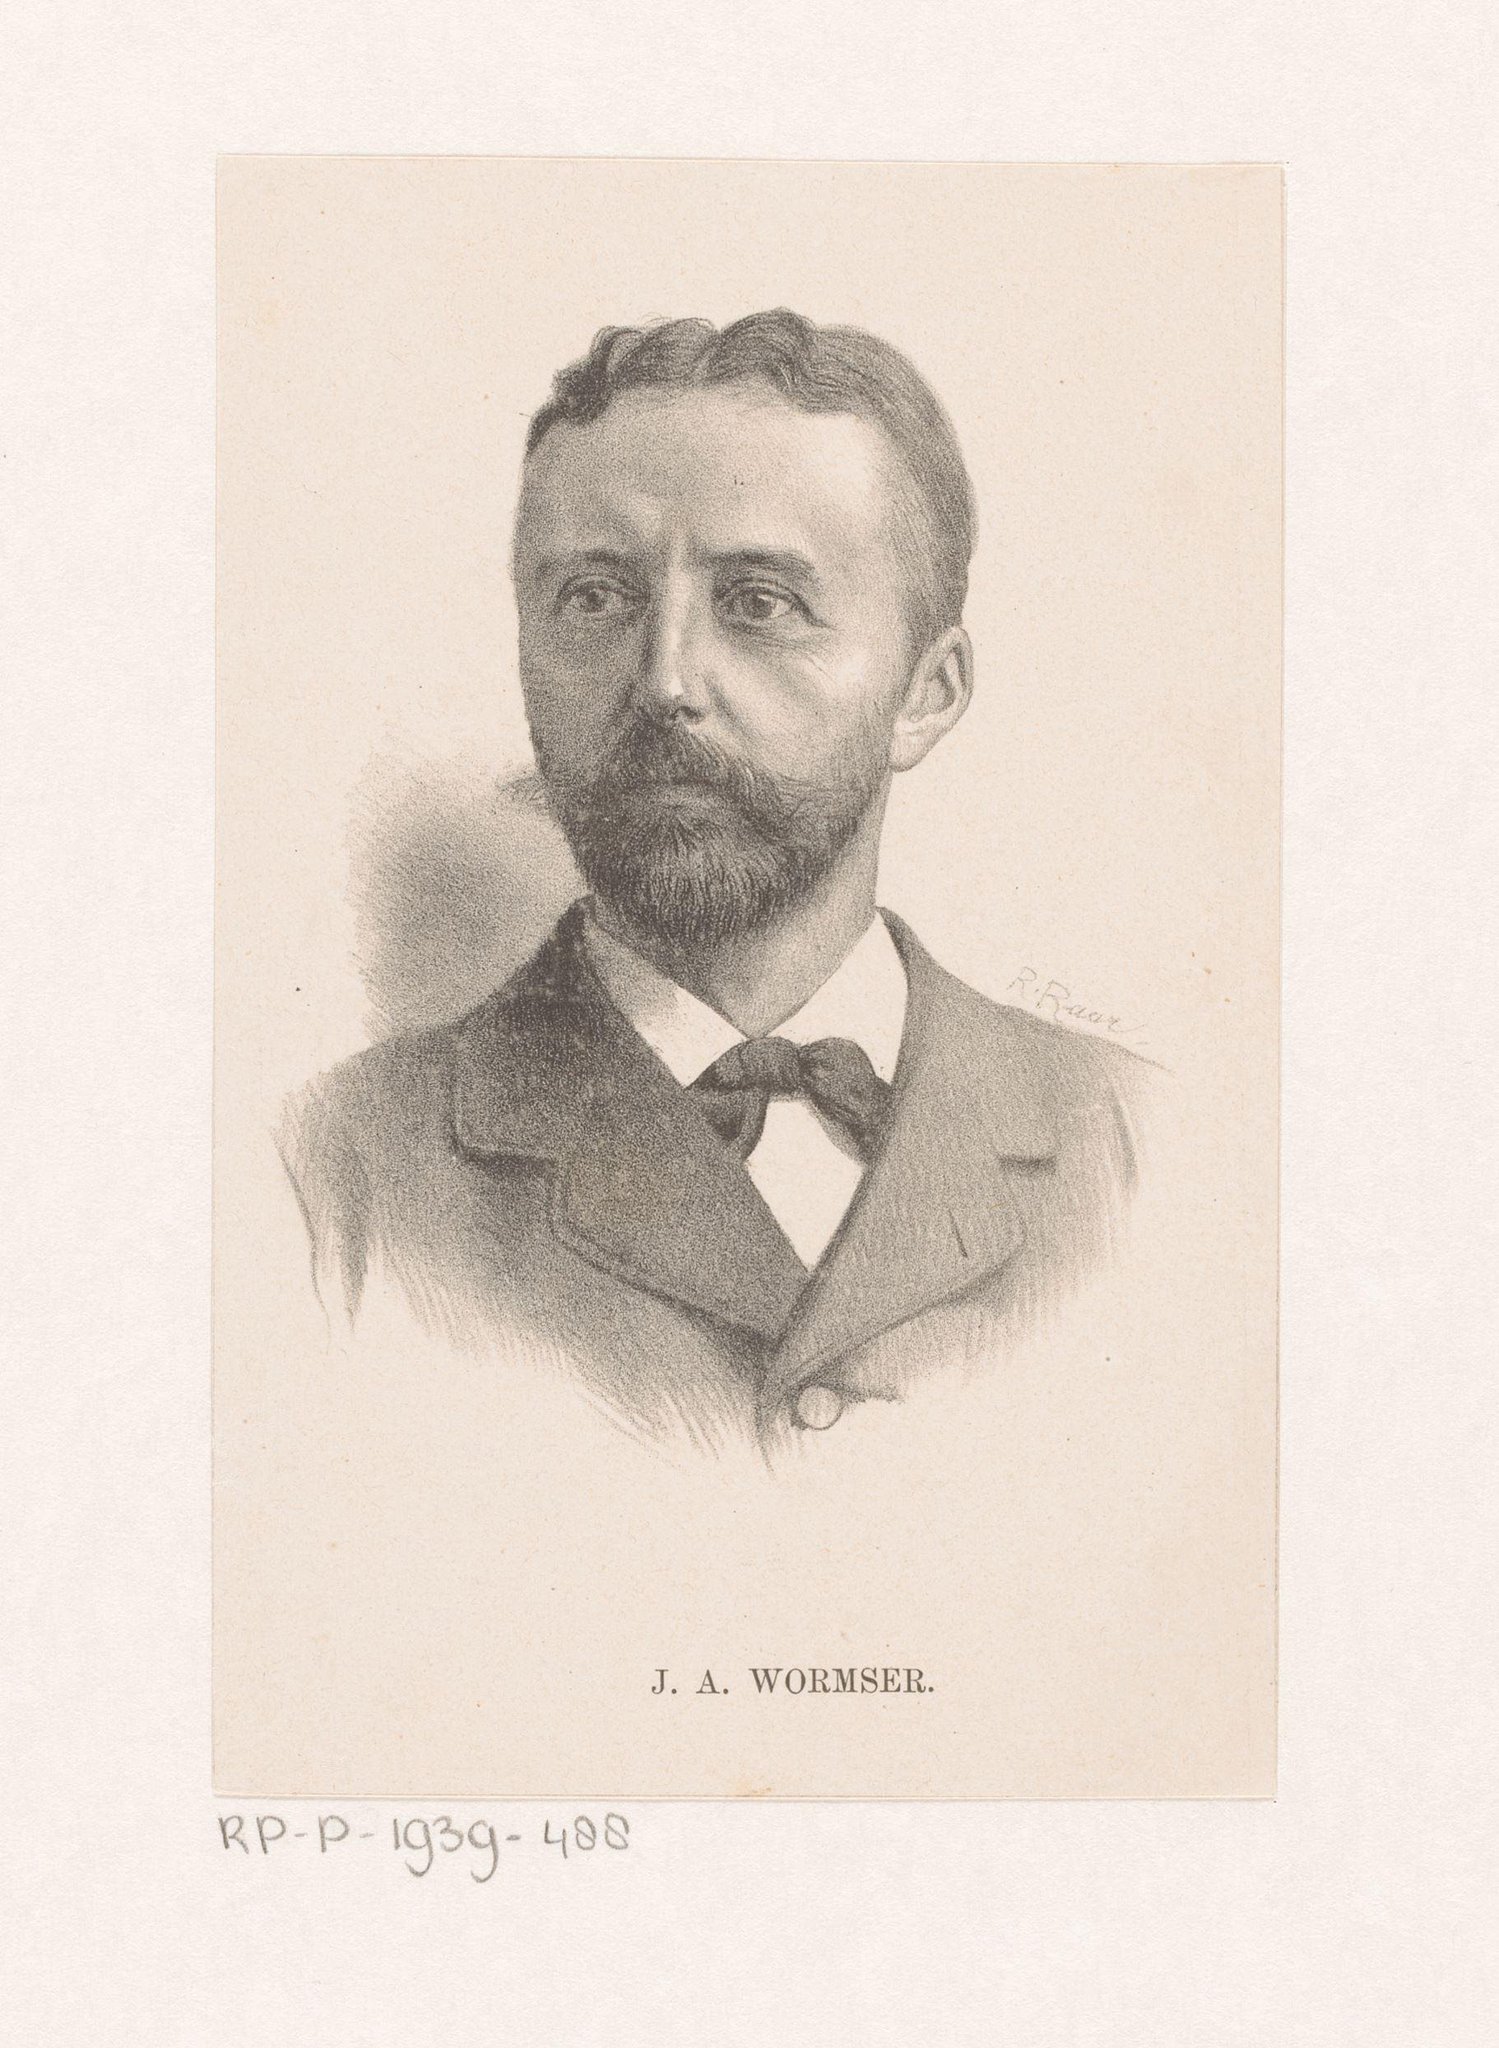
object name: print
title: J.A. Wormser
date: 1865-1906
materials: paper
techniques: lithograph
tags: amsterdam, historical persons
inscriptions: collector's mark: Lugt 2760, collector's mark: Lugt 2166